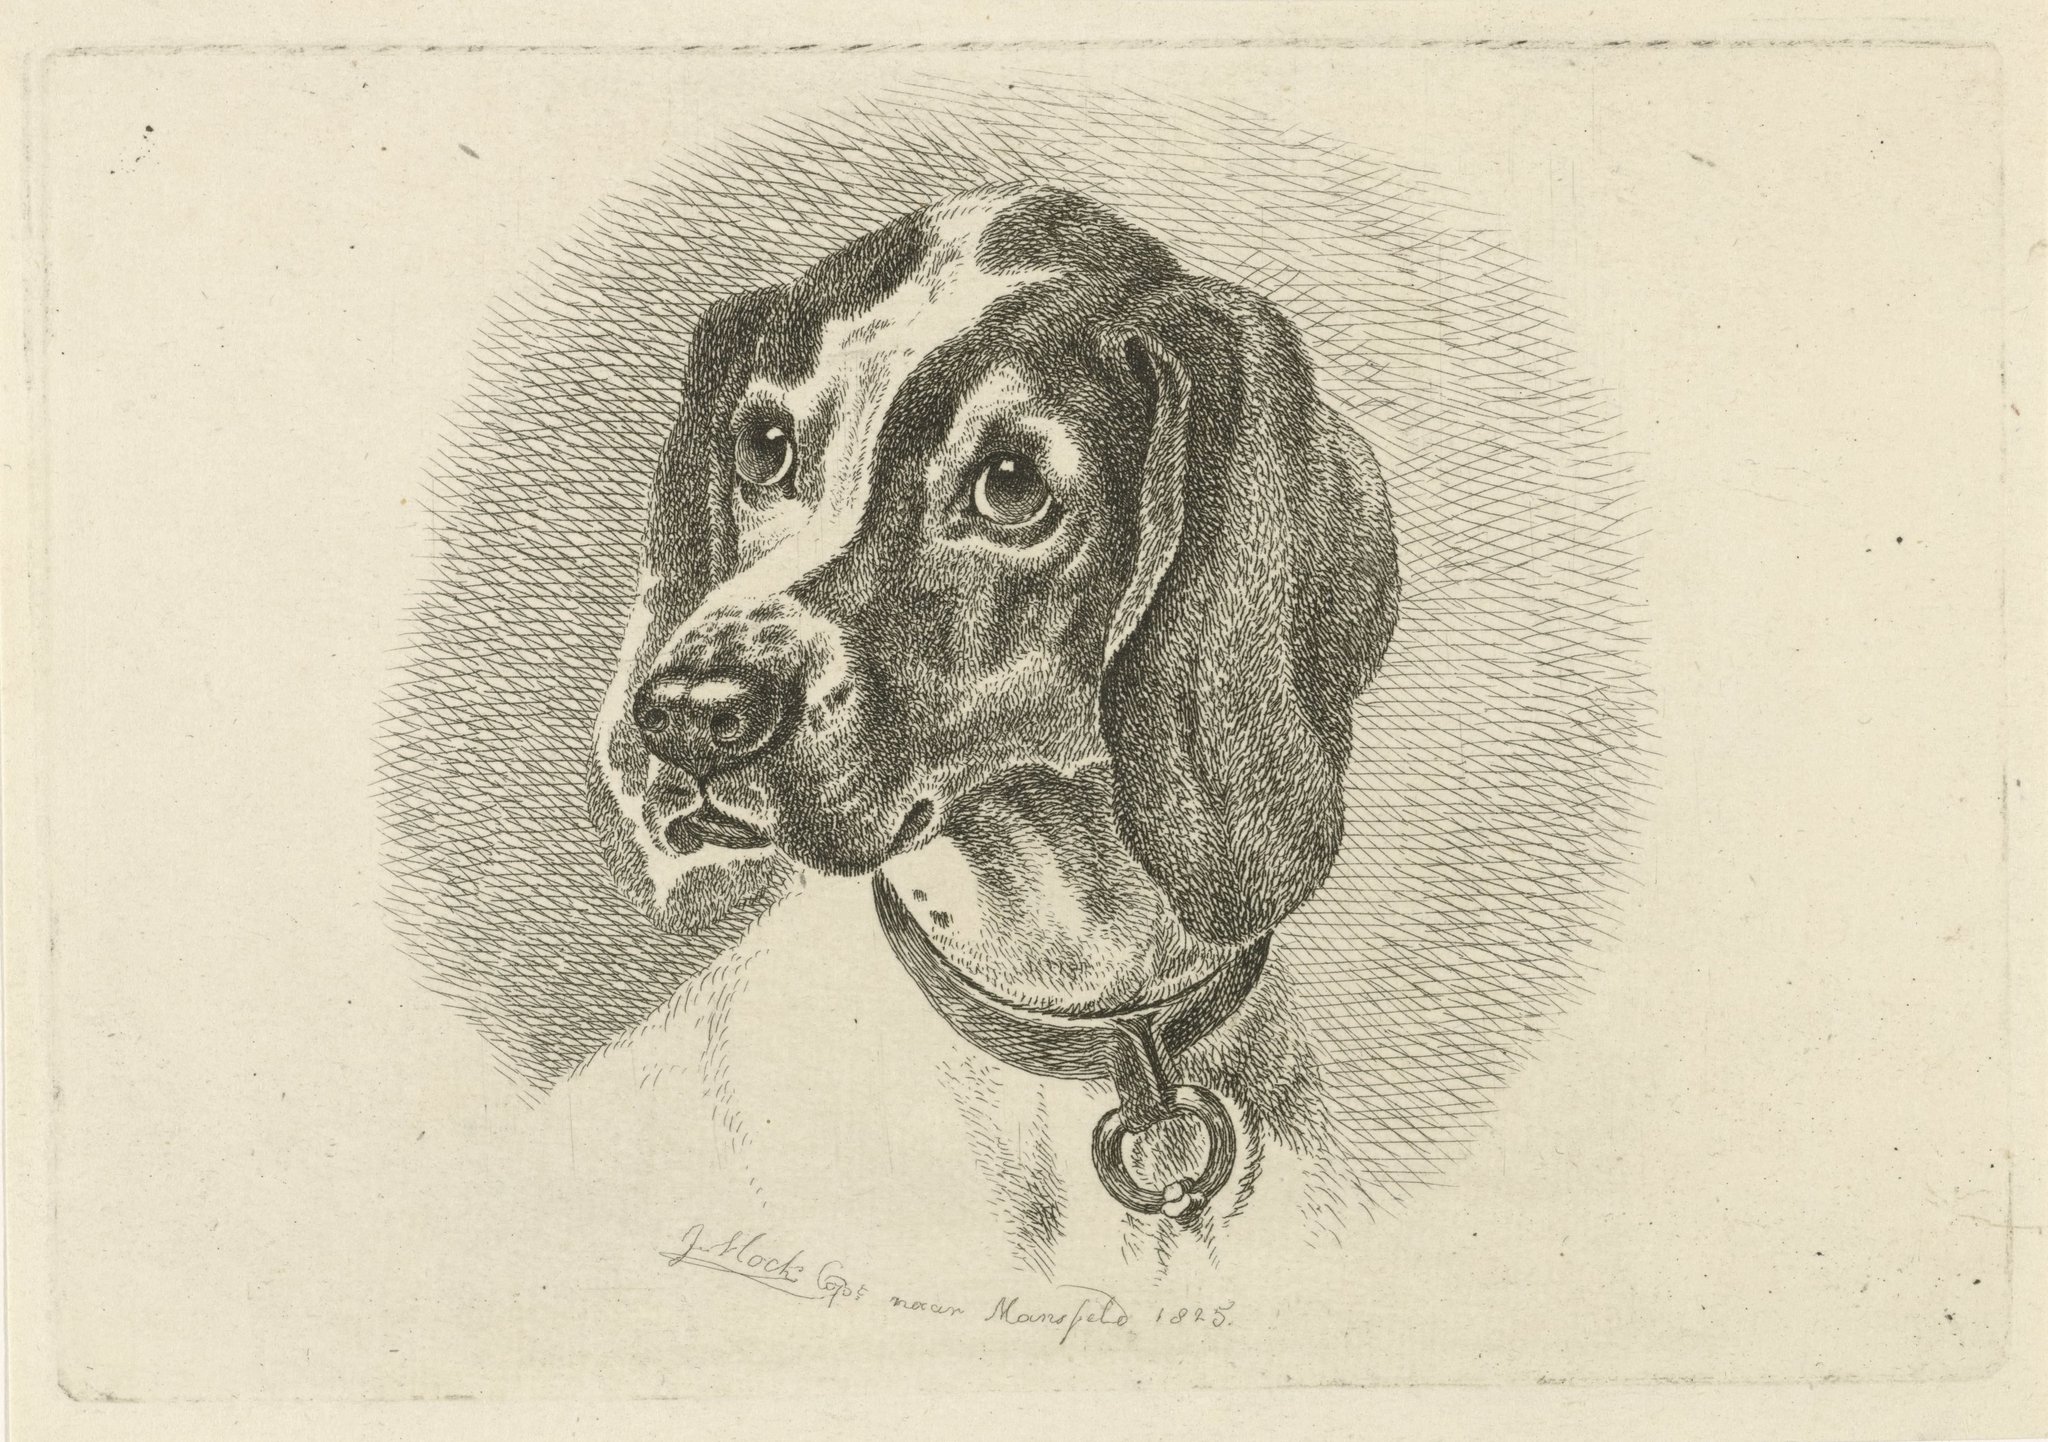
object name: print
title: Hondenkop met een halsband met ring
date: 1825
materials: paper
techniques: etching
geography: netherlands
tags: collar (of a dog), dog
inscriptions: collector's mark: Lugt 2228